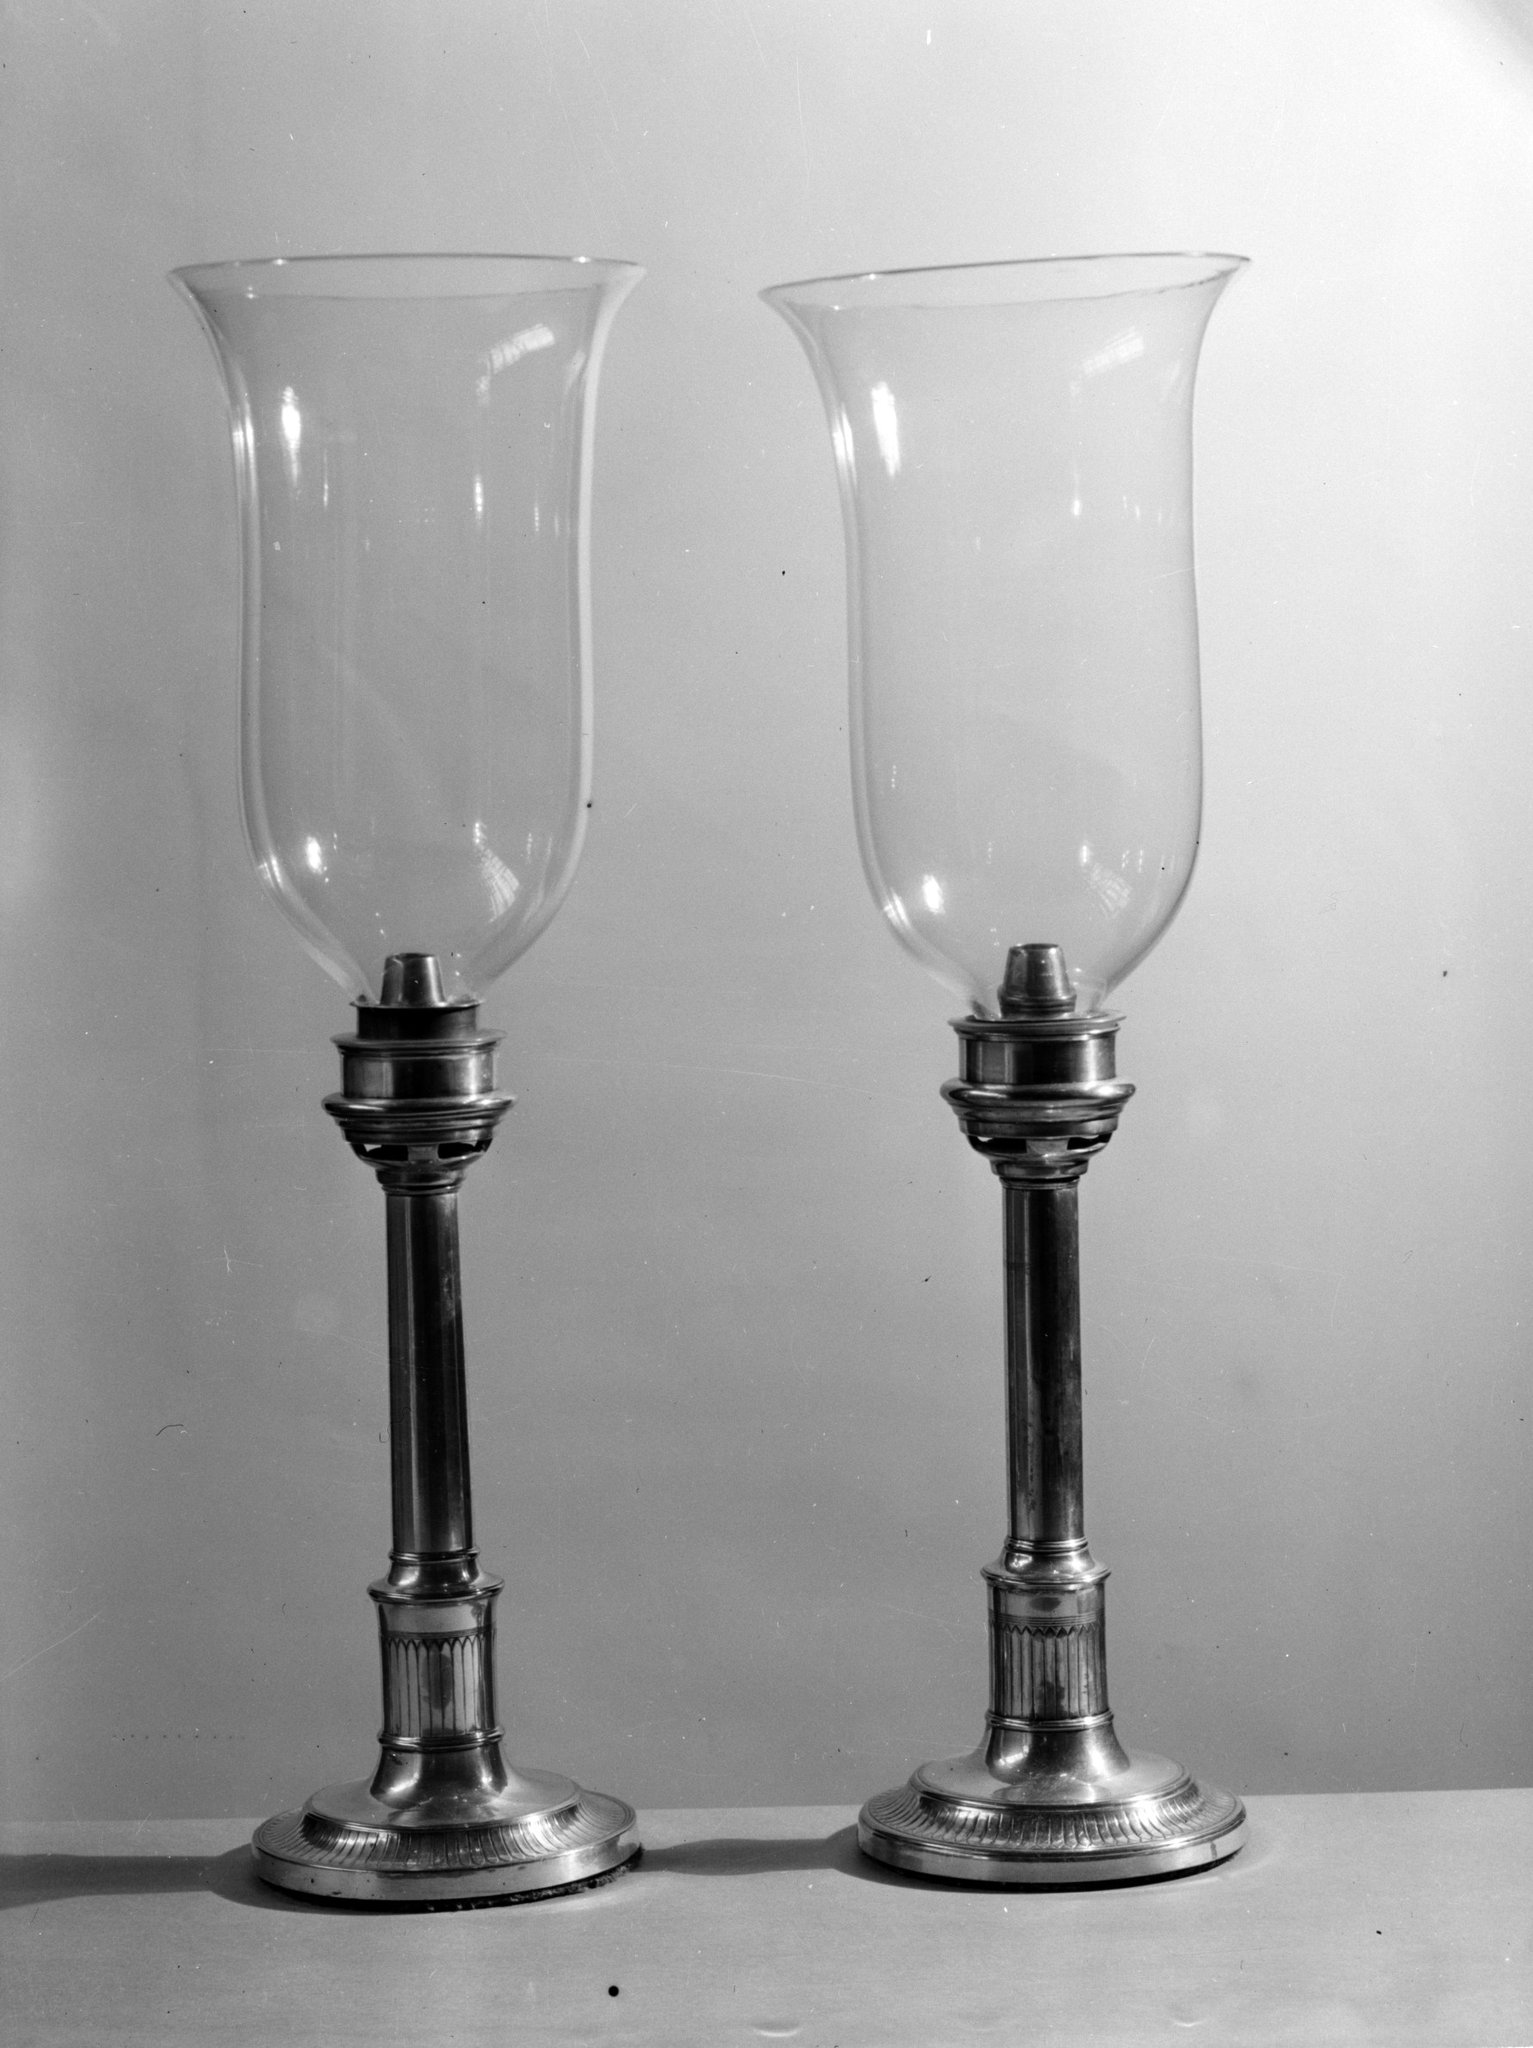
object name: candlestick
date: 1790-1800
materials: silver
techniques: glassblowing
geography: england